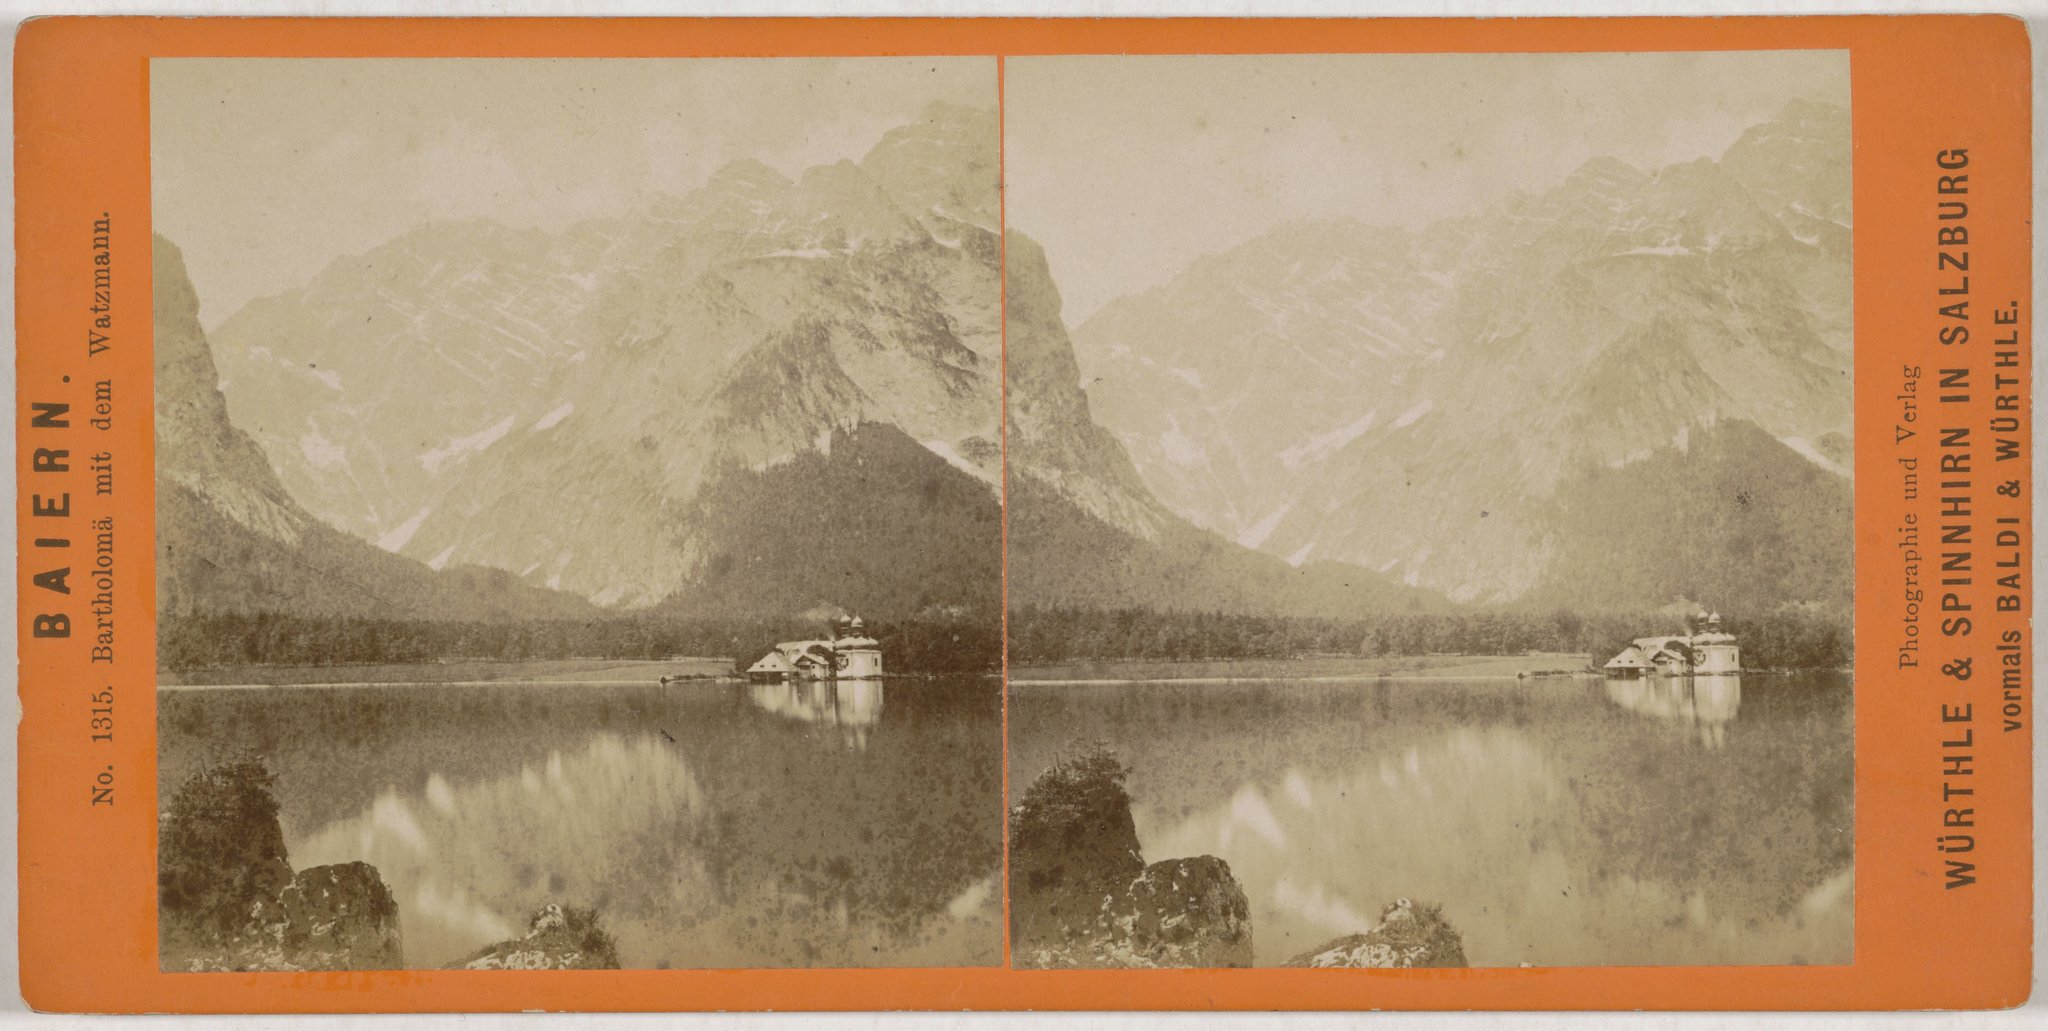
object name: stereograph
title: Bedevaartkapel de Sint-Bartholomeüskerk aan de Köningssee en de Watzmann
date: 1881-1892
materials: cardboard, paper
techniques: albumen print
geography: salzburg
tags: lake, church (exterior) - qq - small church, chapel, mountains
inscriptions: number: ‘No. 1315.’